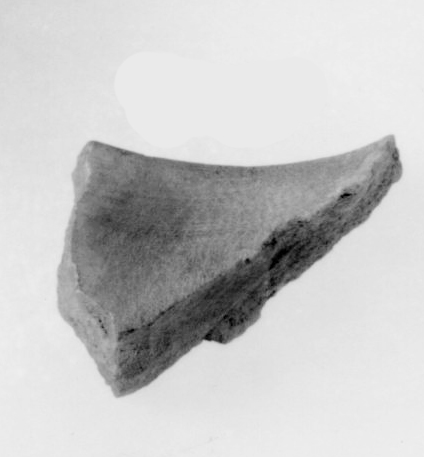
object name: canopic box, siptah, top surface, inner surface, jar lip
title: Fragment of the Top Surface of Siptah's Canopic Chest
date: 1194-1188 BCE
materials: stone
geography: egypt